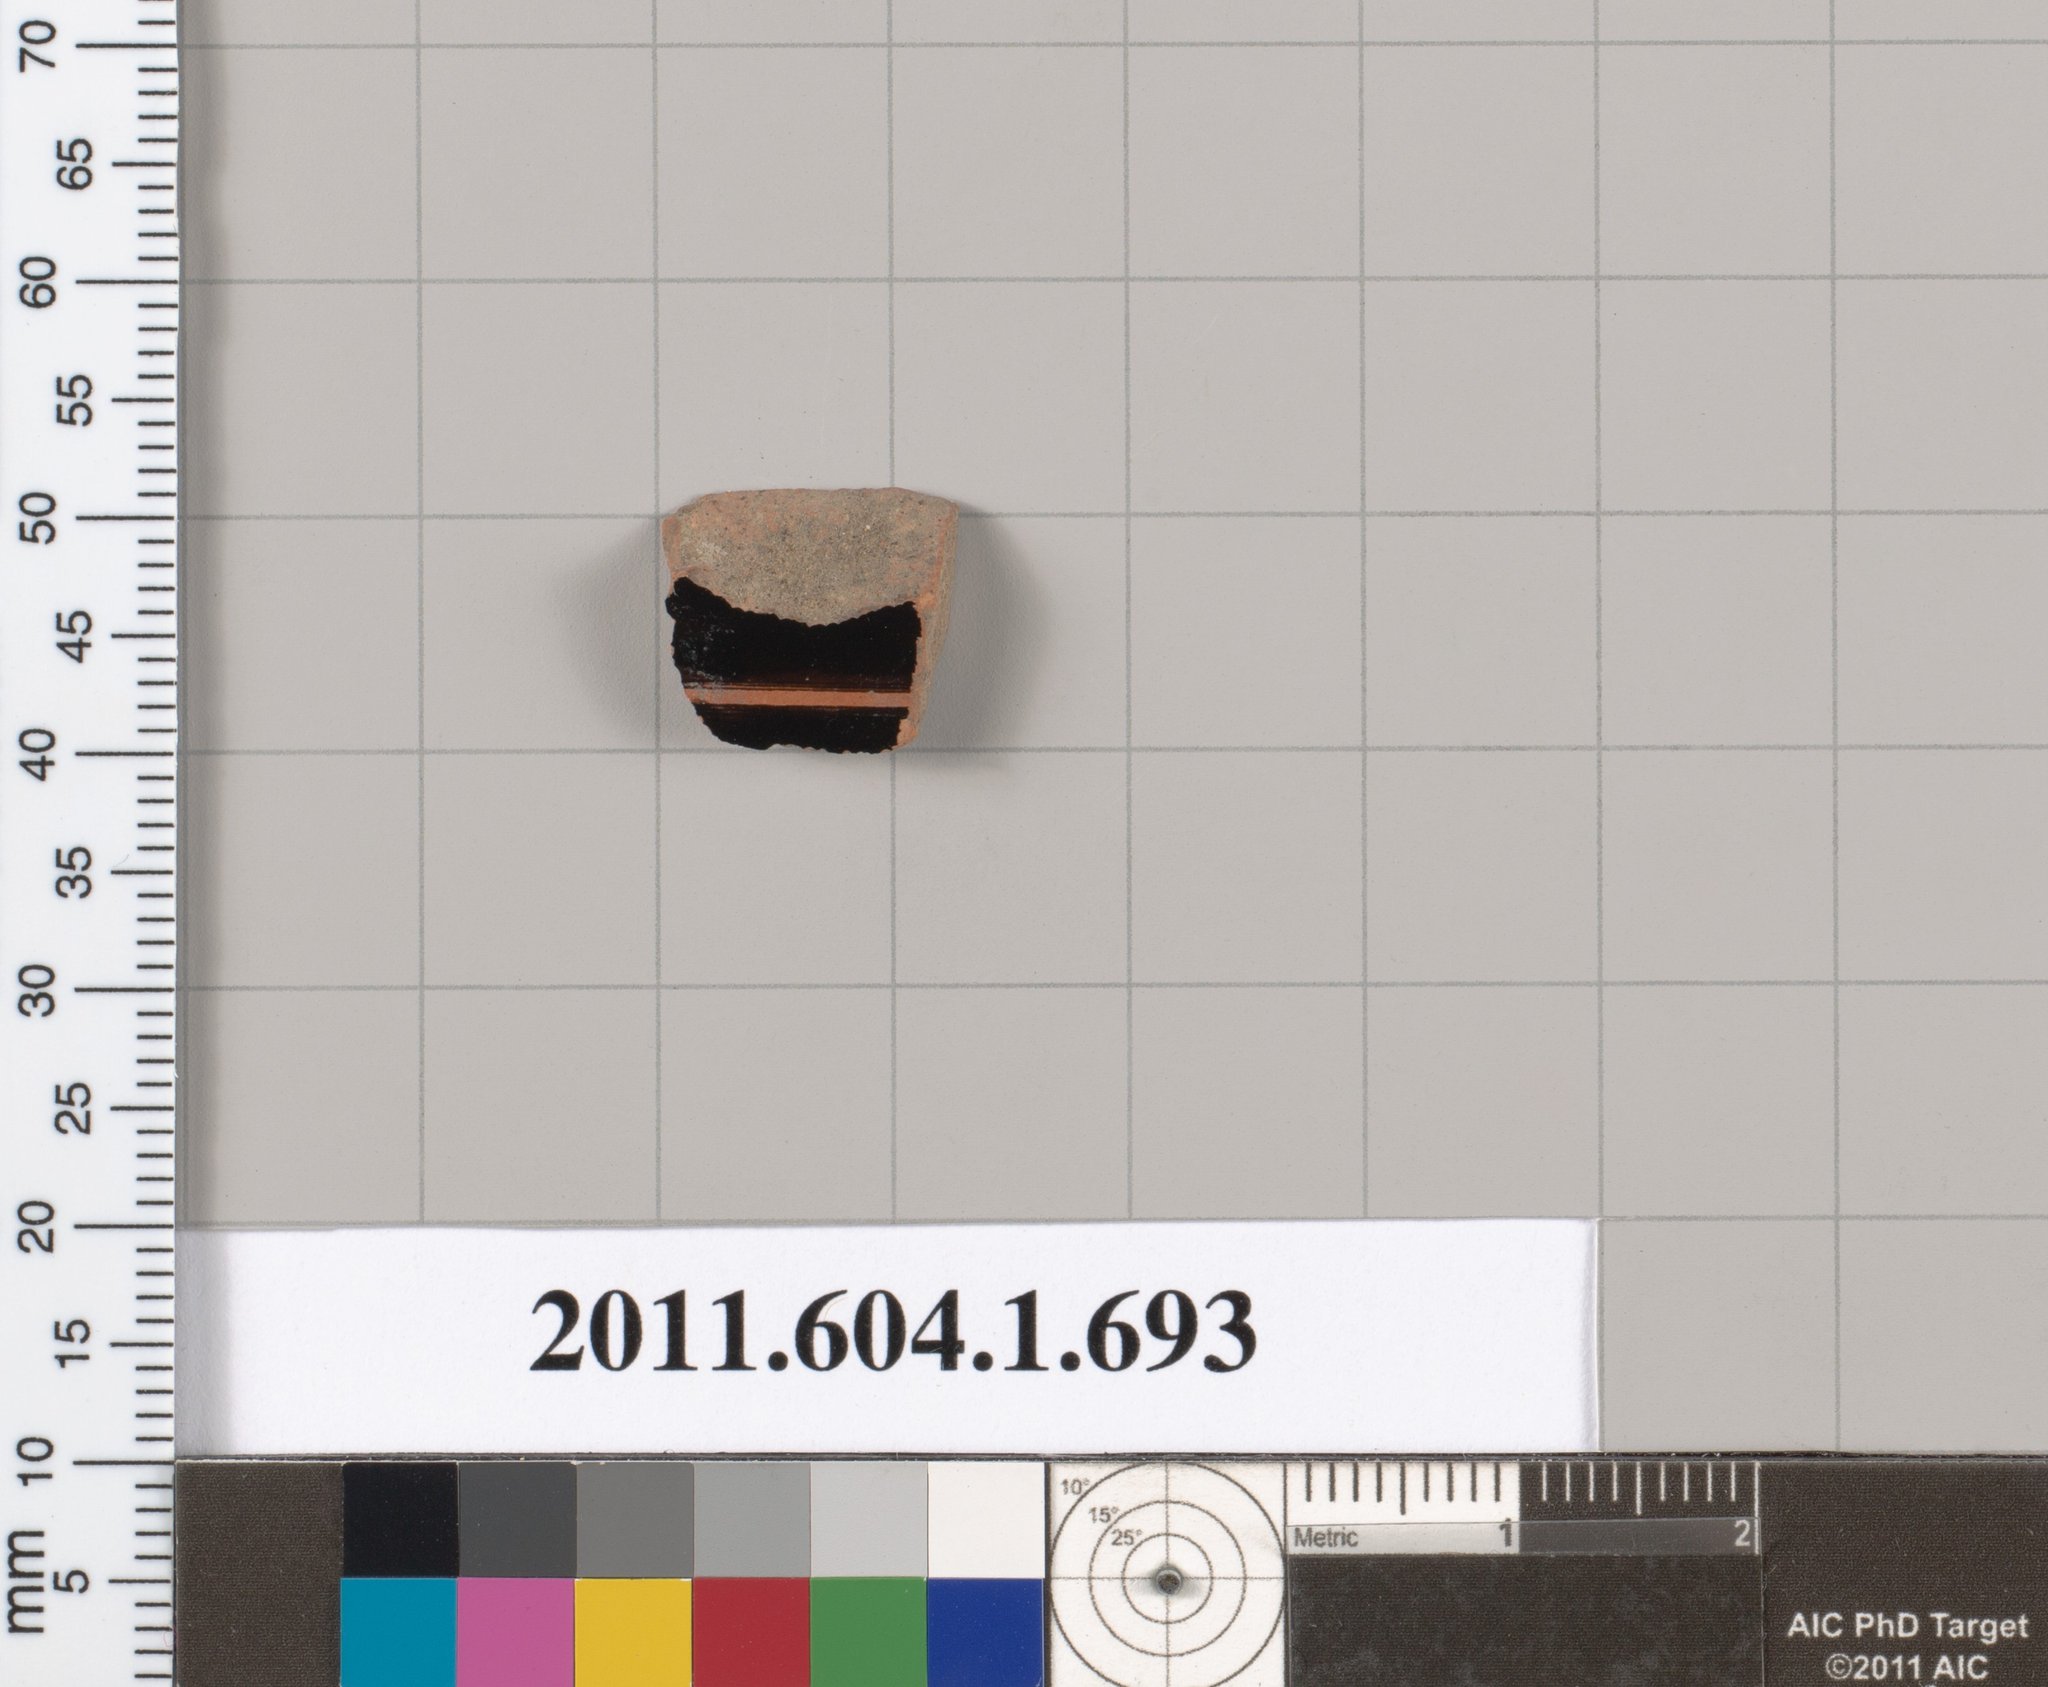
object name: kylix fragment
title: Terracotta fragment of a kylix (drinking cup)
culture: greek, attic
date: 475-451 BCE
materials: terracotta